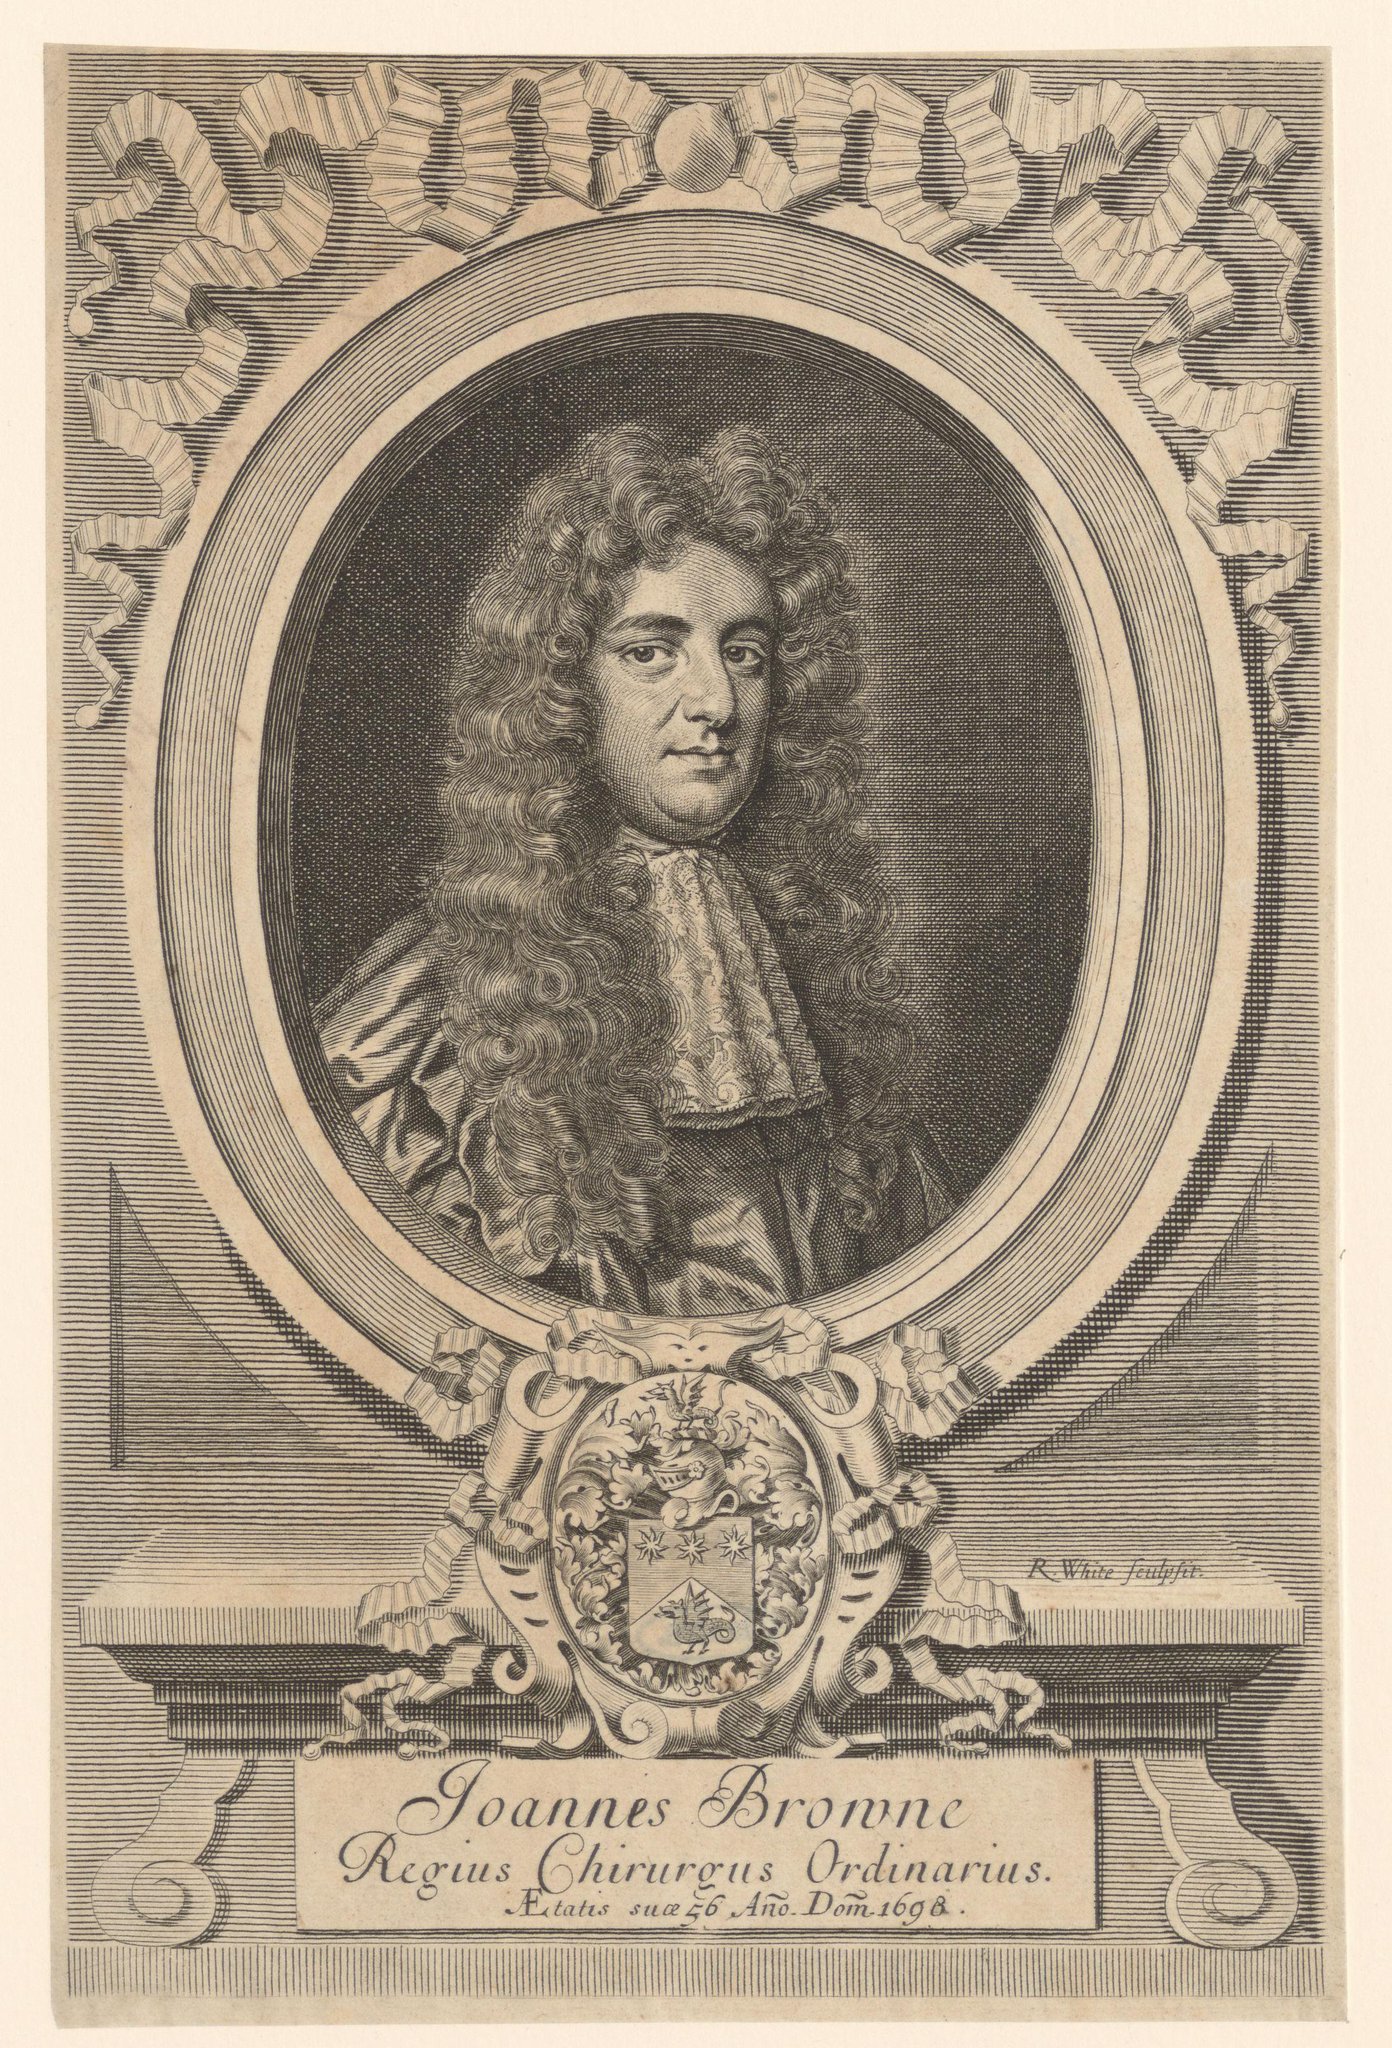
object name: print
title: Portret van John Browne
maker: robert white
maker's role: print maker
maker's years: 1645-1703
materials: paper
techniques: engraving, etching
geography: london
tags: historical persons, physiology and anatomy (+ portrait of scholar, scientist)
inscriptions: inscription: ‘Robert[...] now R. Drinkwater [...] 1729 Richard Drinkwater Richard Drinkwater’, collector's mark: Lugt 2228